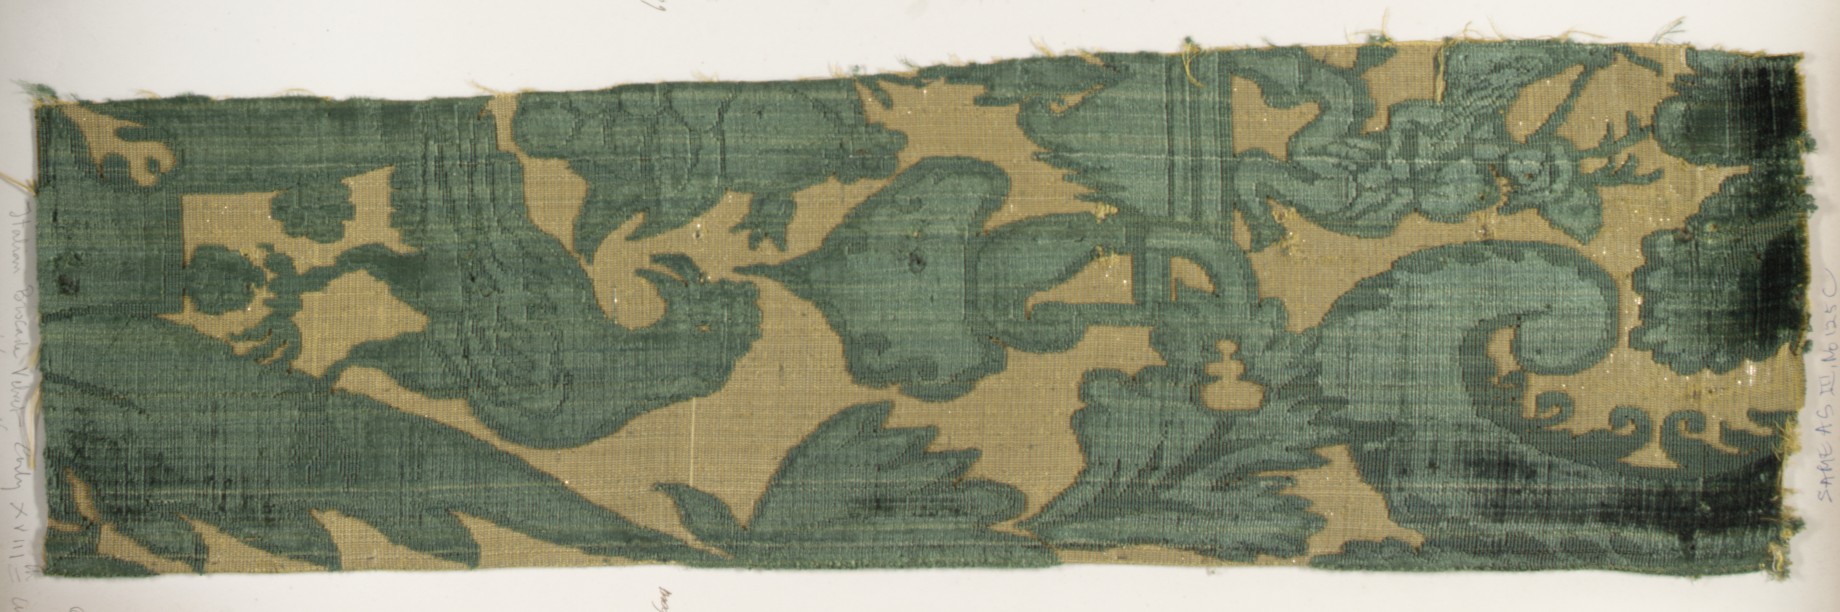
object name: fragment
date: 1701-1800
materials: metal thread, silk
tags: flowers